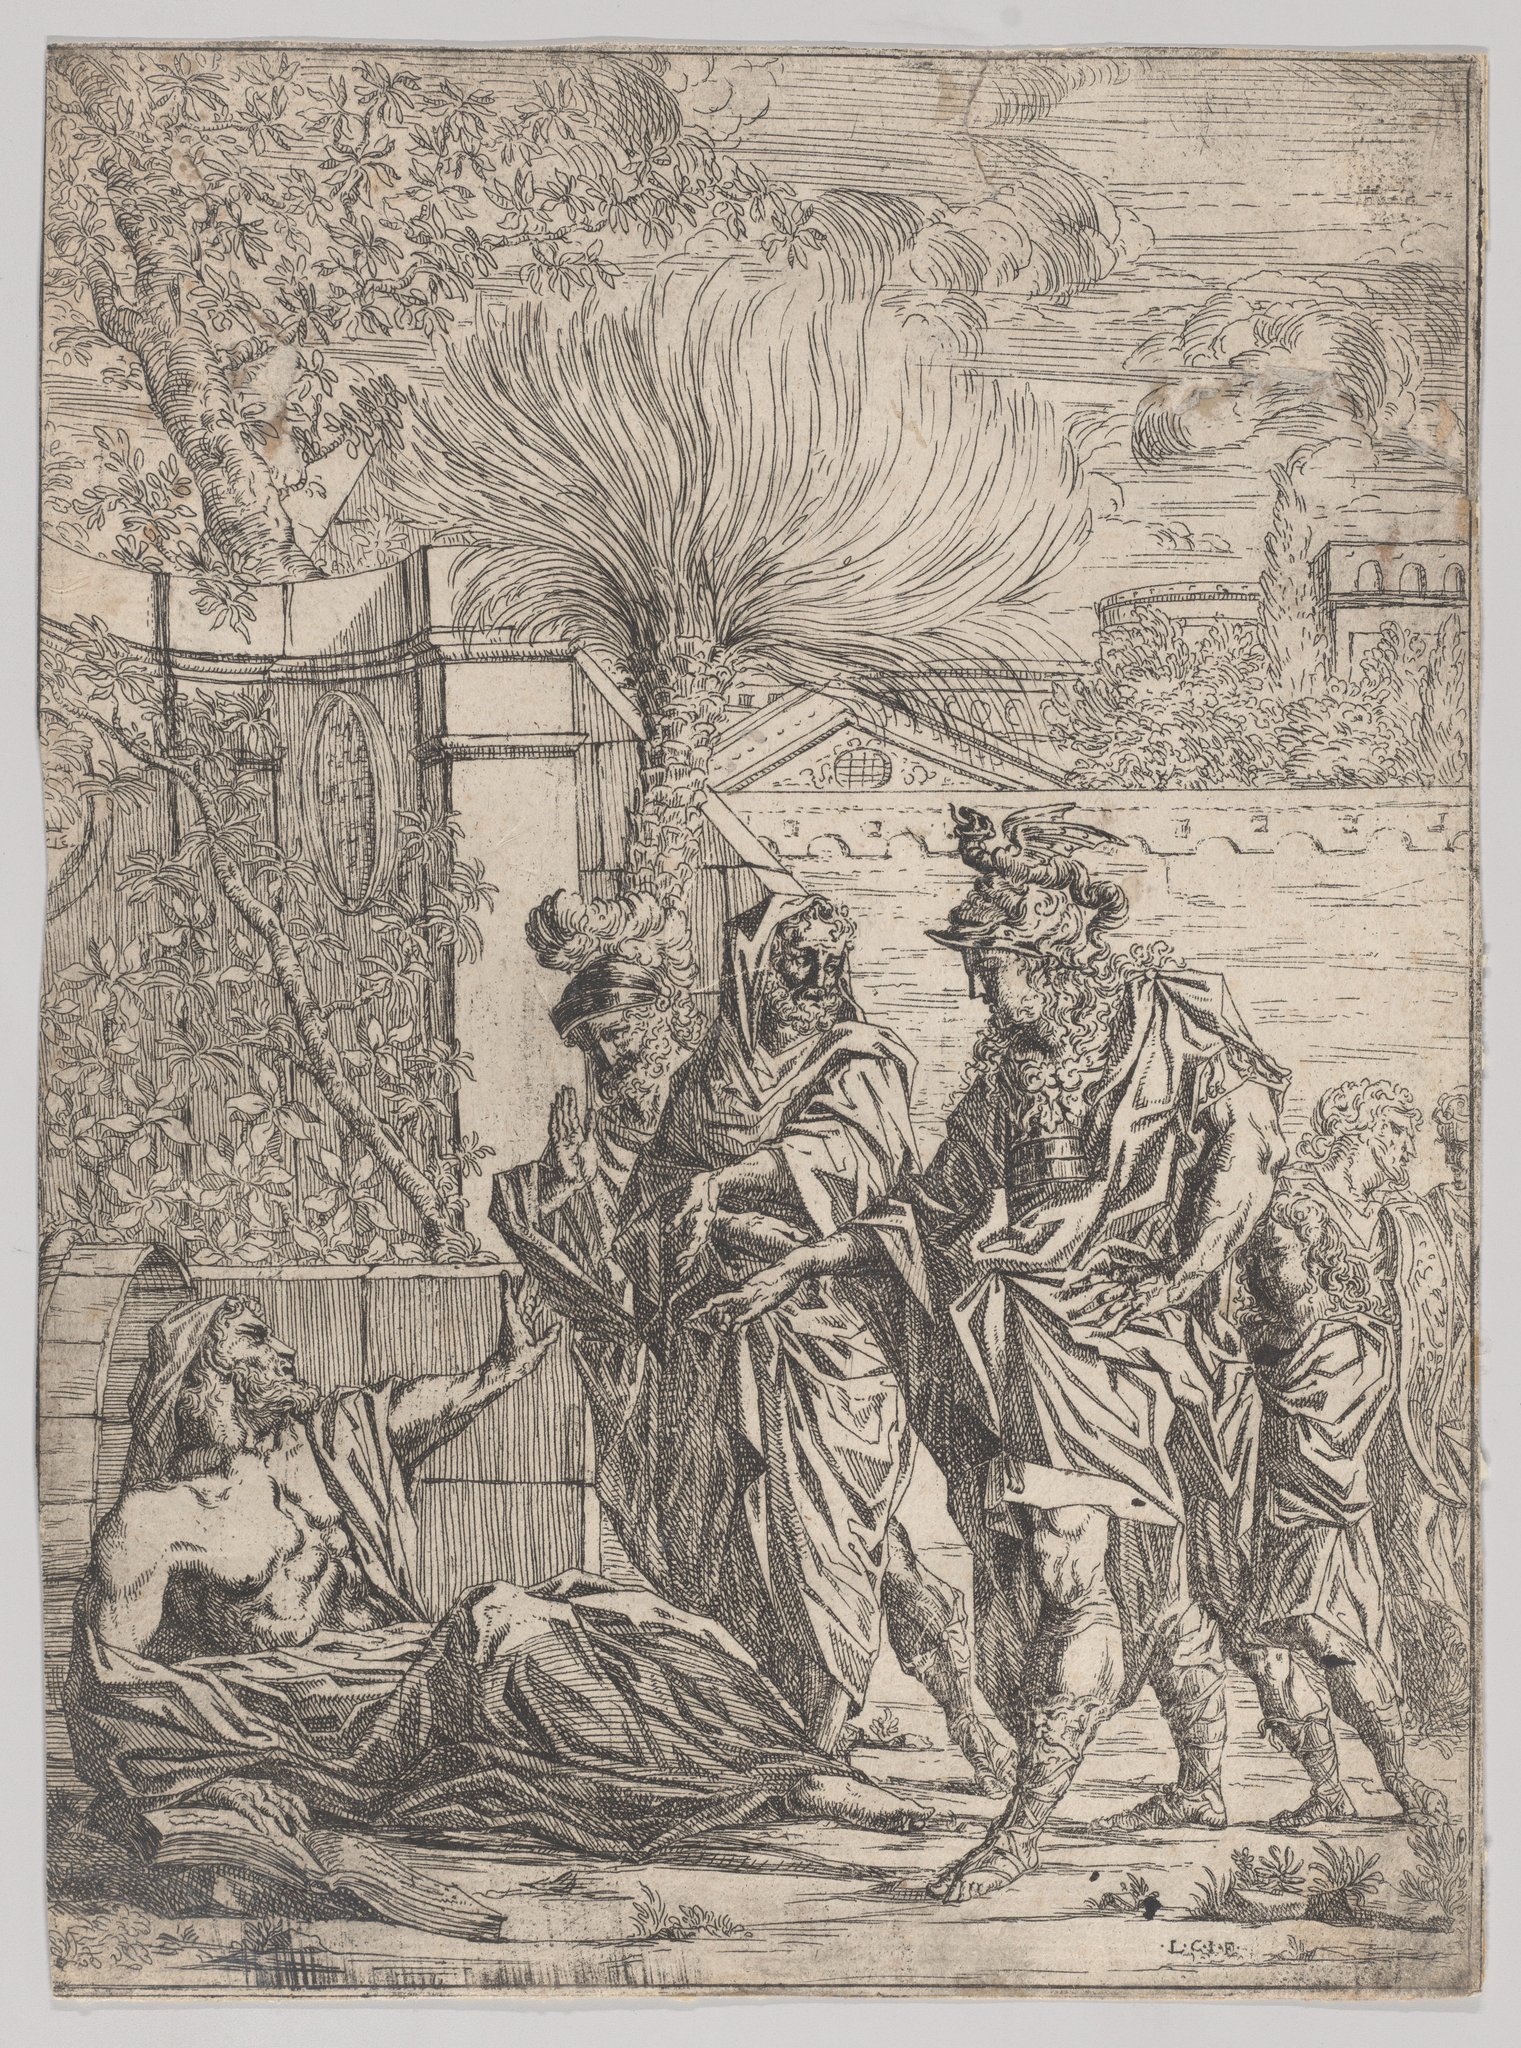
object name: print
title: Alexander the Great meeting Diogenes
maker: Anonymous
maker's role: artist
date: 1580-1640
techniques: etching